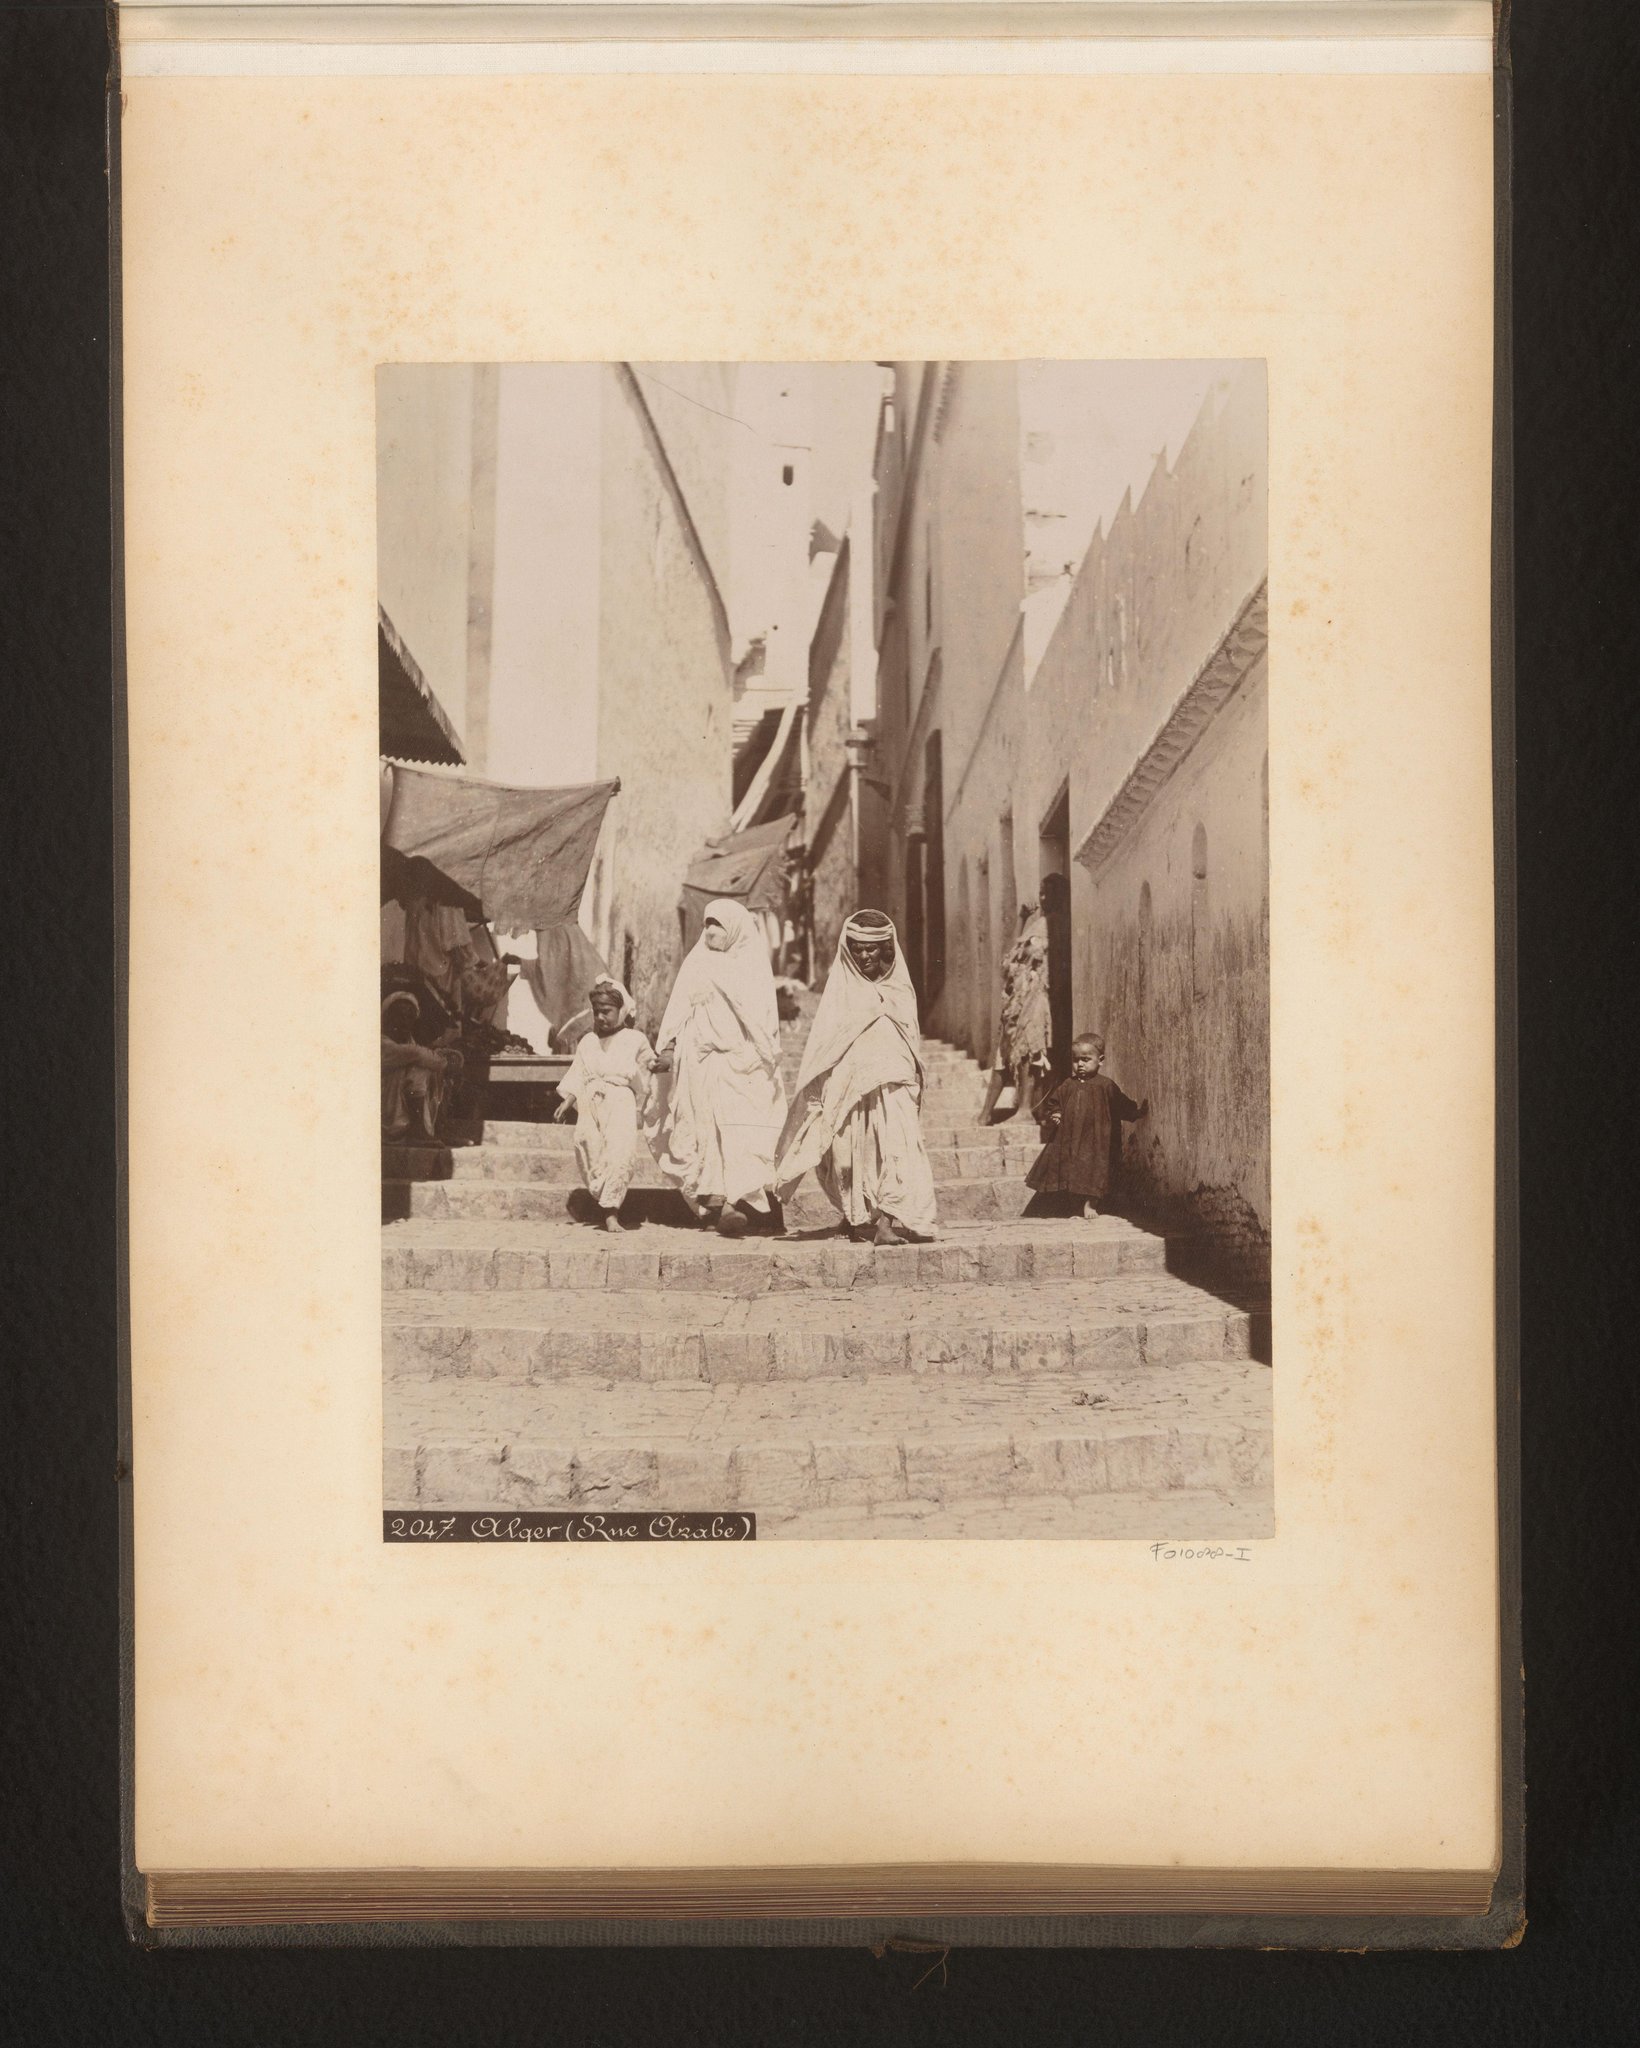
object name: album leaf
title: Straatgezicht te Algiers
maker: Anonymous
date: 1880-1900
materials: photographic support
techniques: albumen print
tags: flight of steps, historical persons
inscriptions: number: ‘2047’